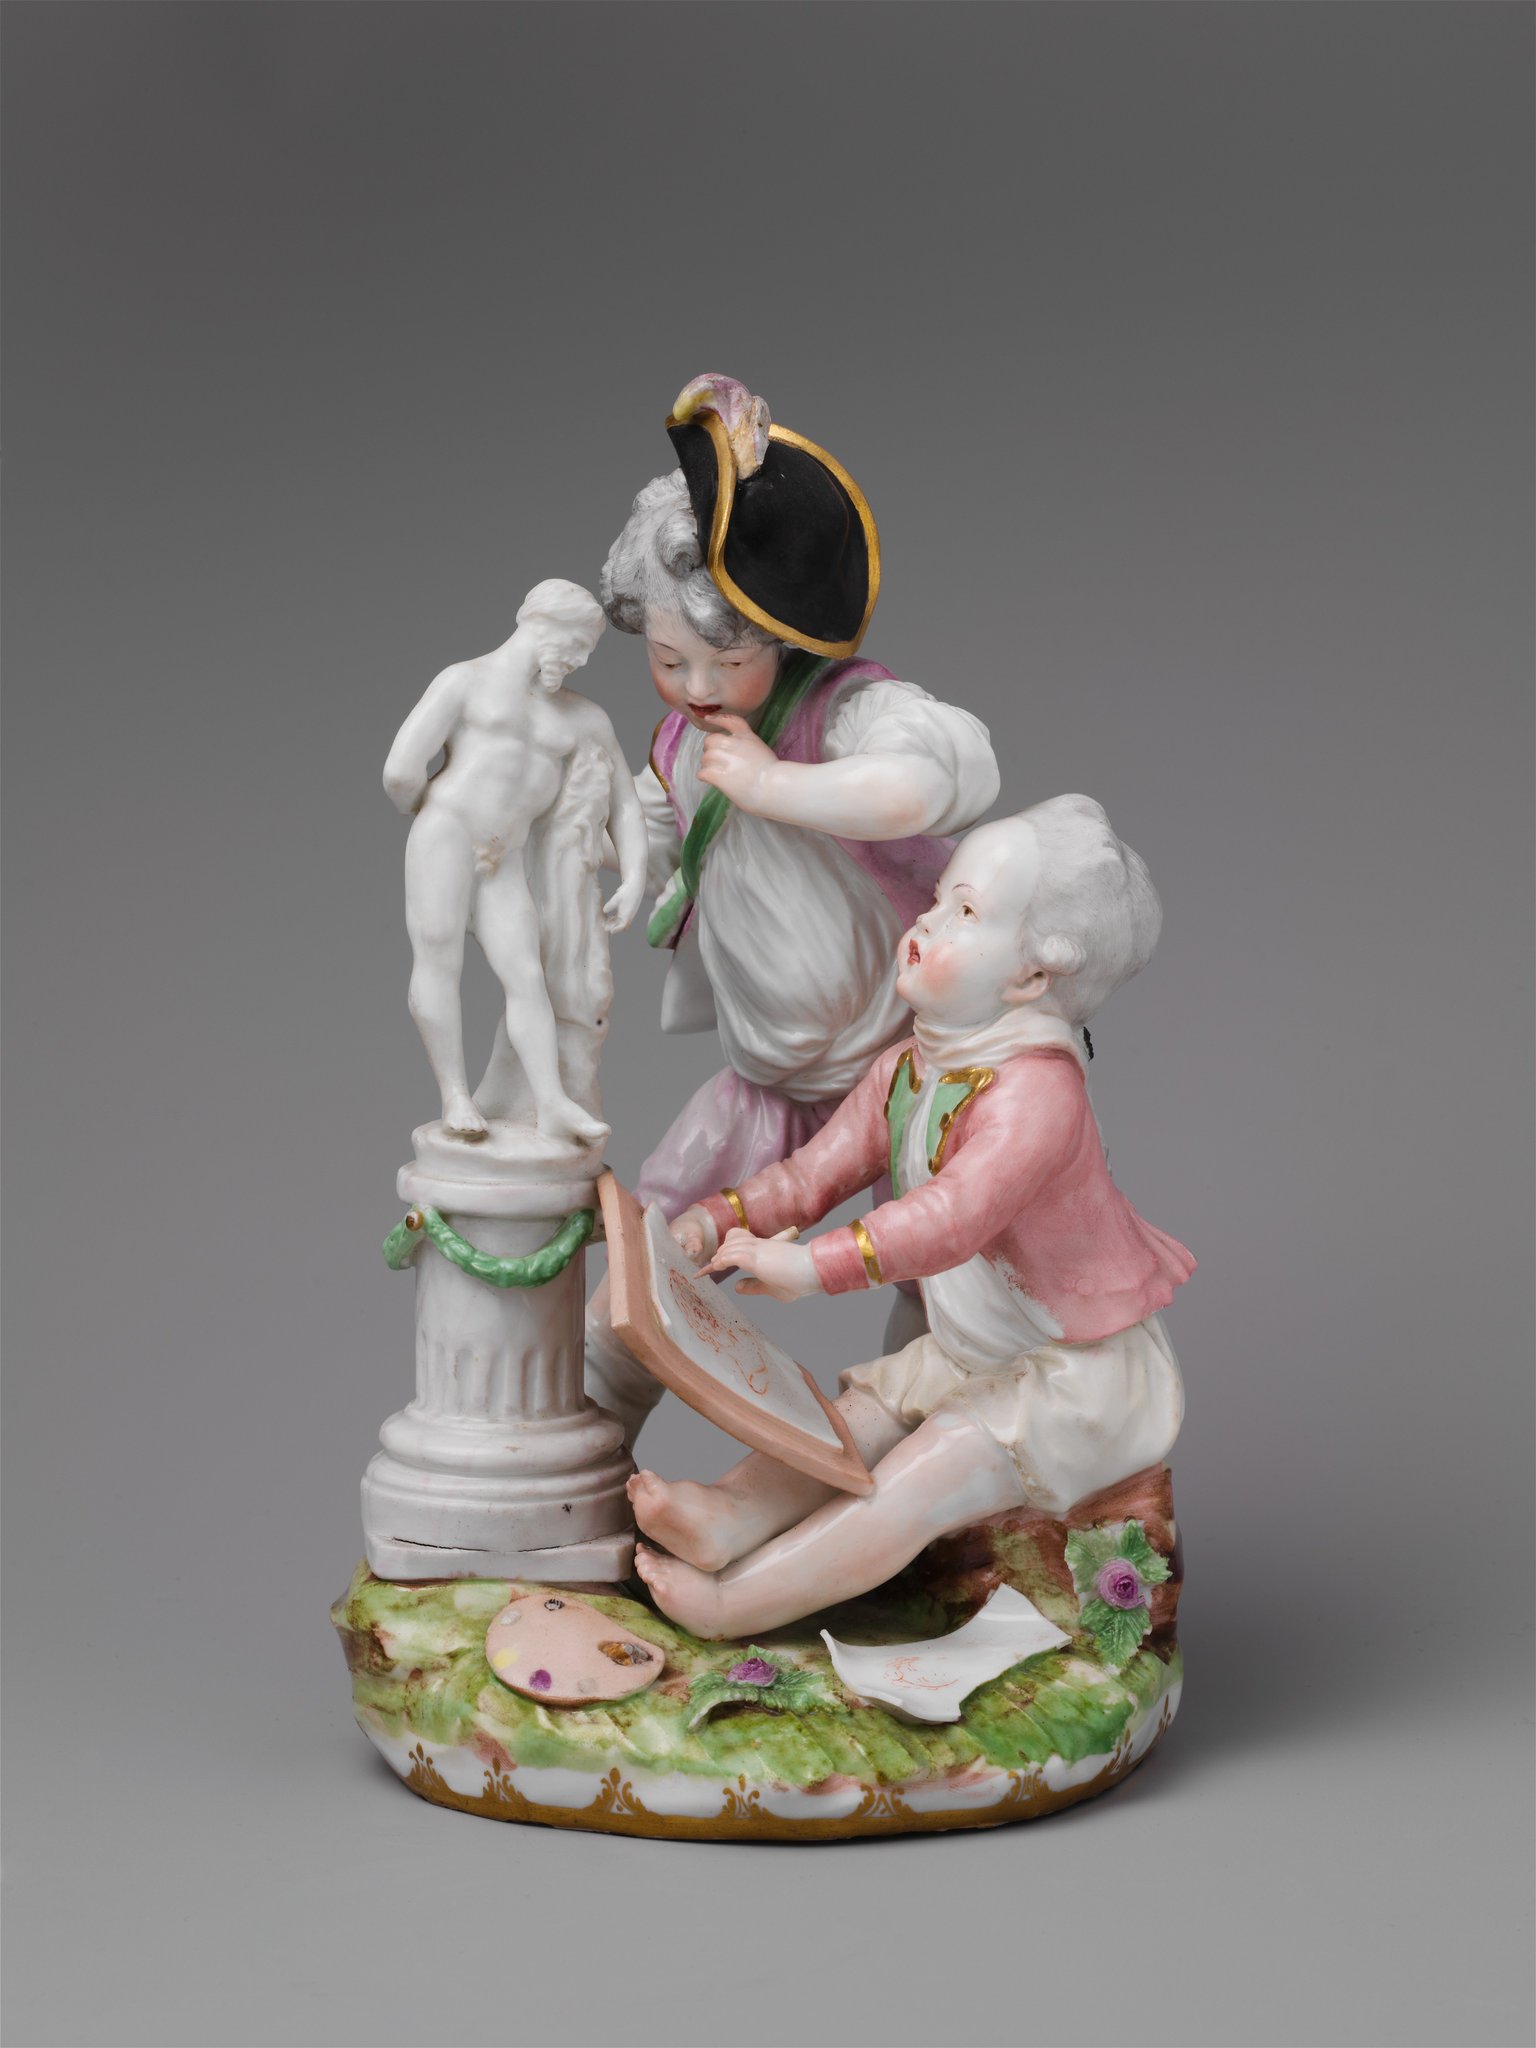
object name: group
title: Allegory of the Arts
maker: imperial porcelain manufactory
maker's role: manufactory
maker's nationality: austrian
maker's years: 1744-1864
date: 1770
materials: hard paste porcelain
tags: drawing,male nudes